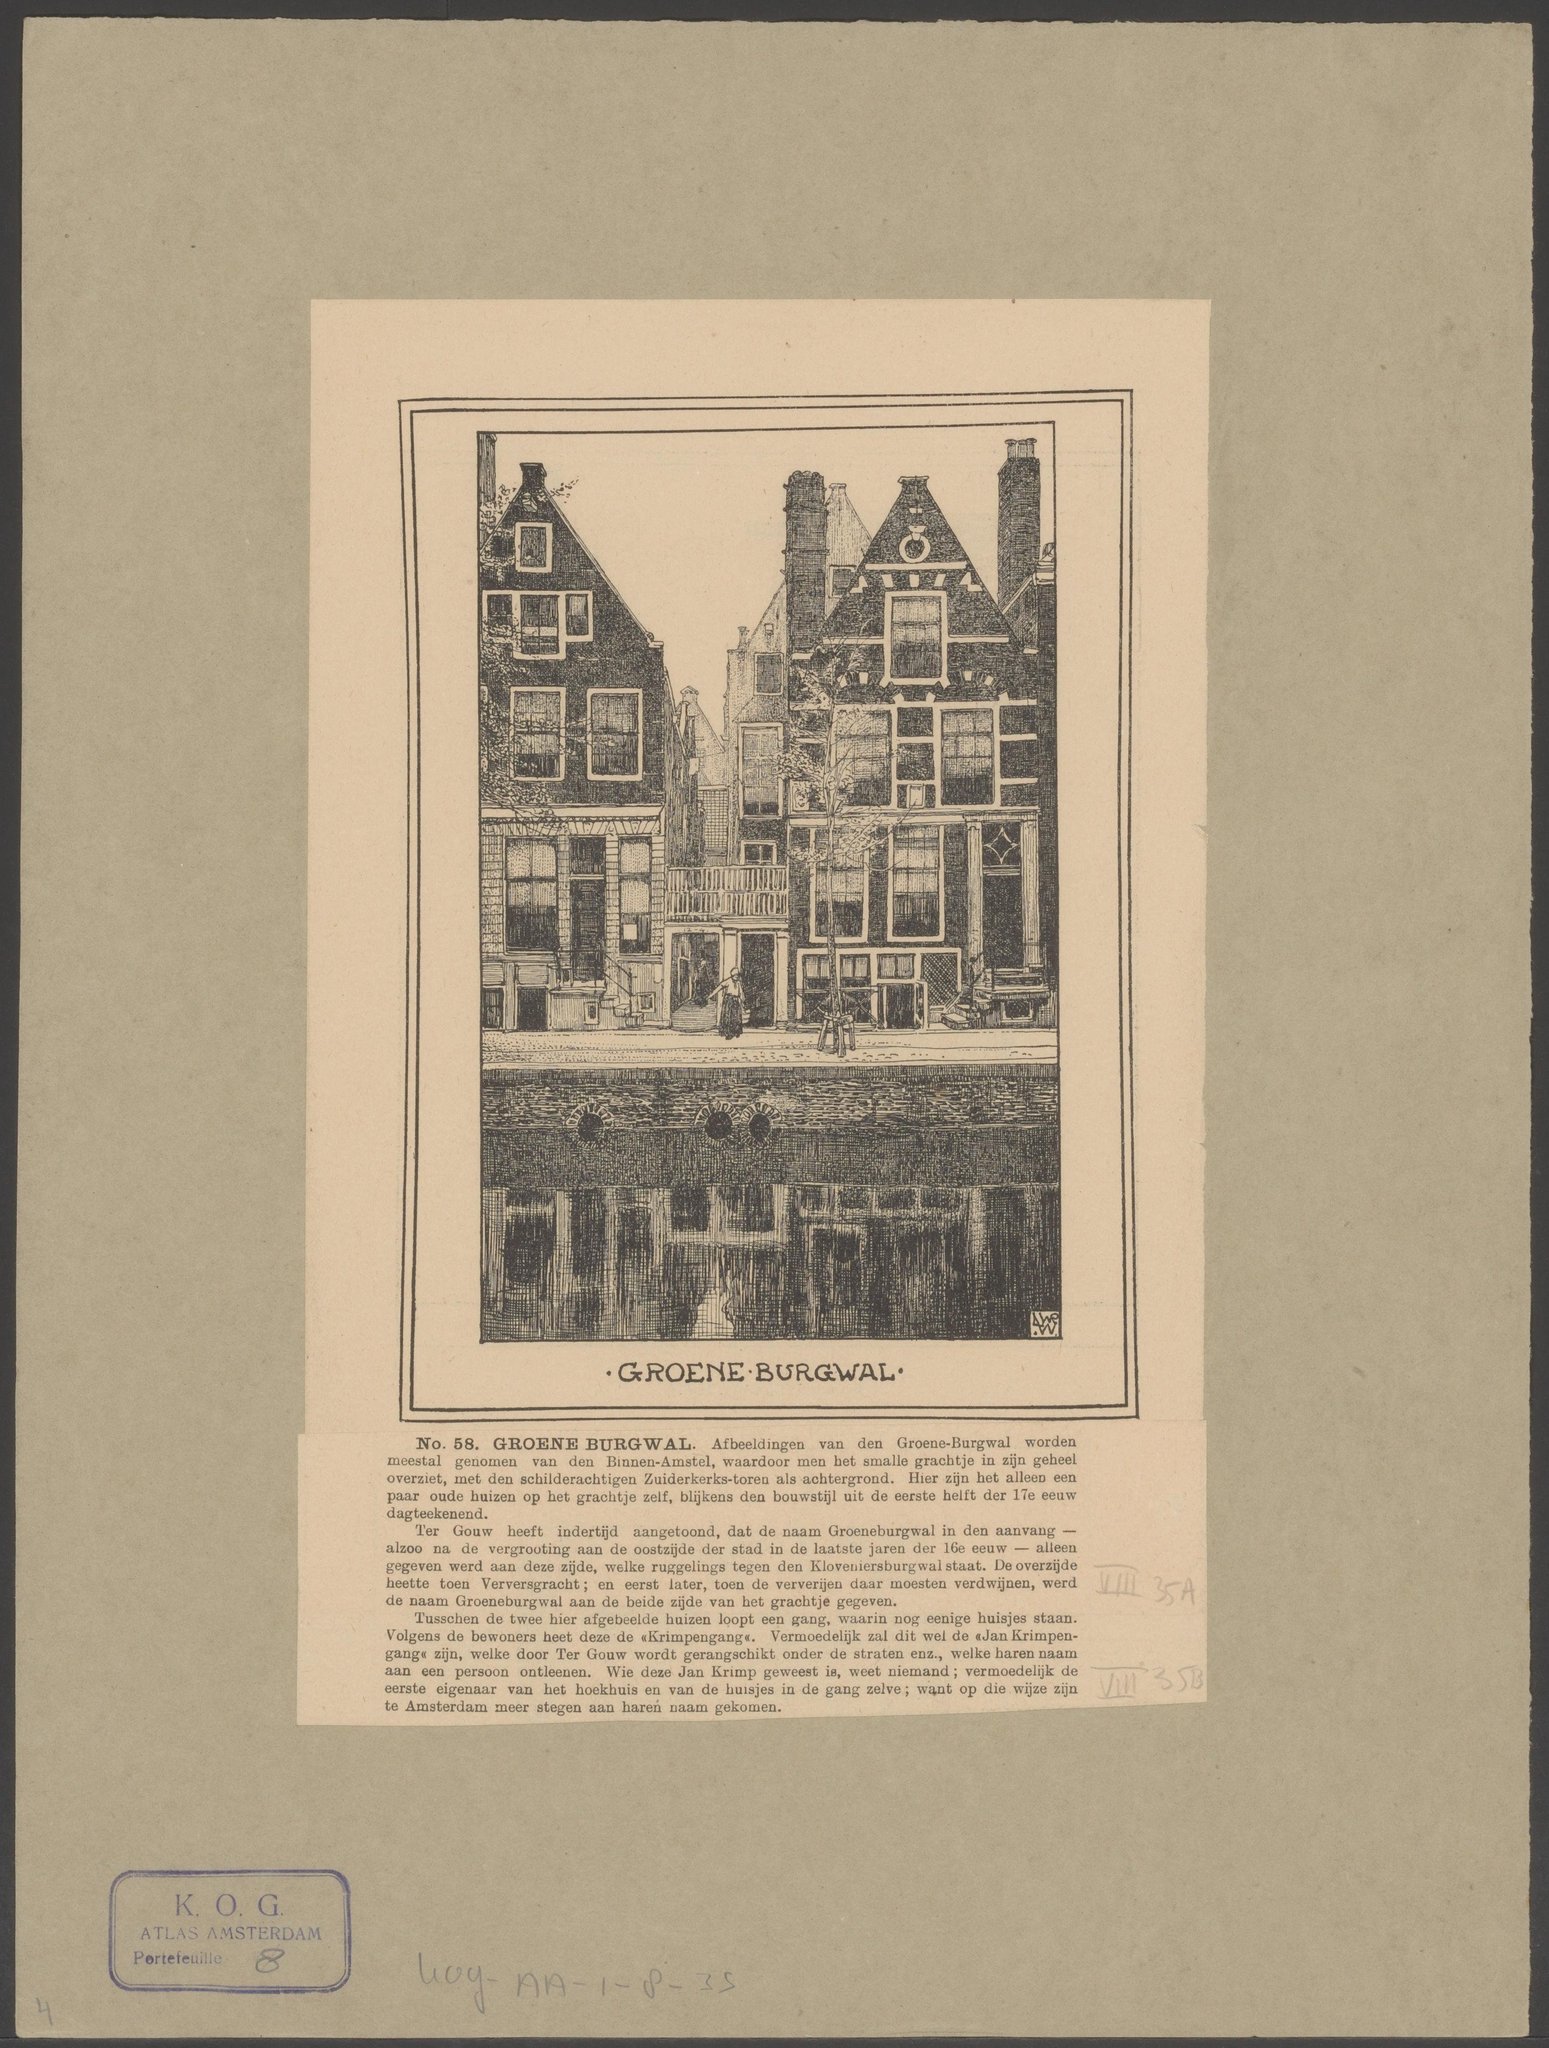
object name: page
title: Gezicht op de Groenburgwal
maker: willem wenckebach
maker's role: designer, draughtsman, painter, print maker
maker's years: 1860-1937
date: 1870-1923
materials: glue, paper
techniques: letterpress printing, line block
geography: amsterdam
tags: city-view in general; 'veduta', canal, the usual house or row of houses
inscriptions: collector's mark: ‘8’ Lugt 1641b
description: Onderwerpsrubriek binnen de Atlas Amsterdam: Galerij Paleis voor Volksvlijt, Gebed zonder end, Geldersche Kade, Gravenstraat, Grimburgwal, Grimnessesluis, Groeneburgwal.